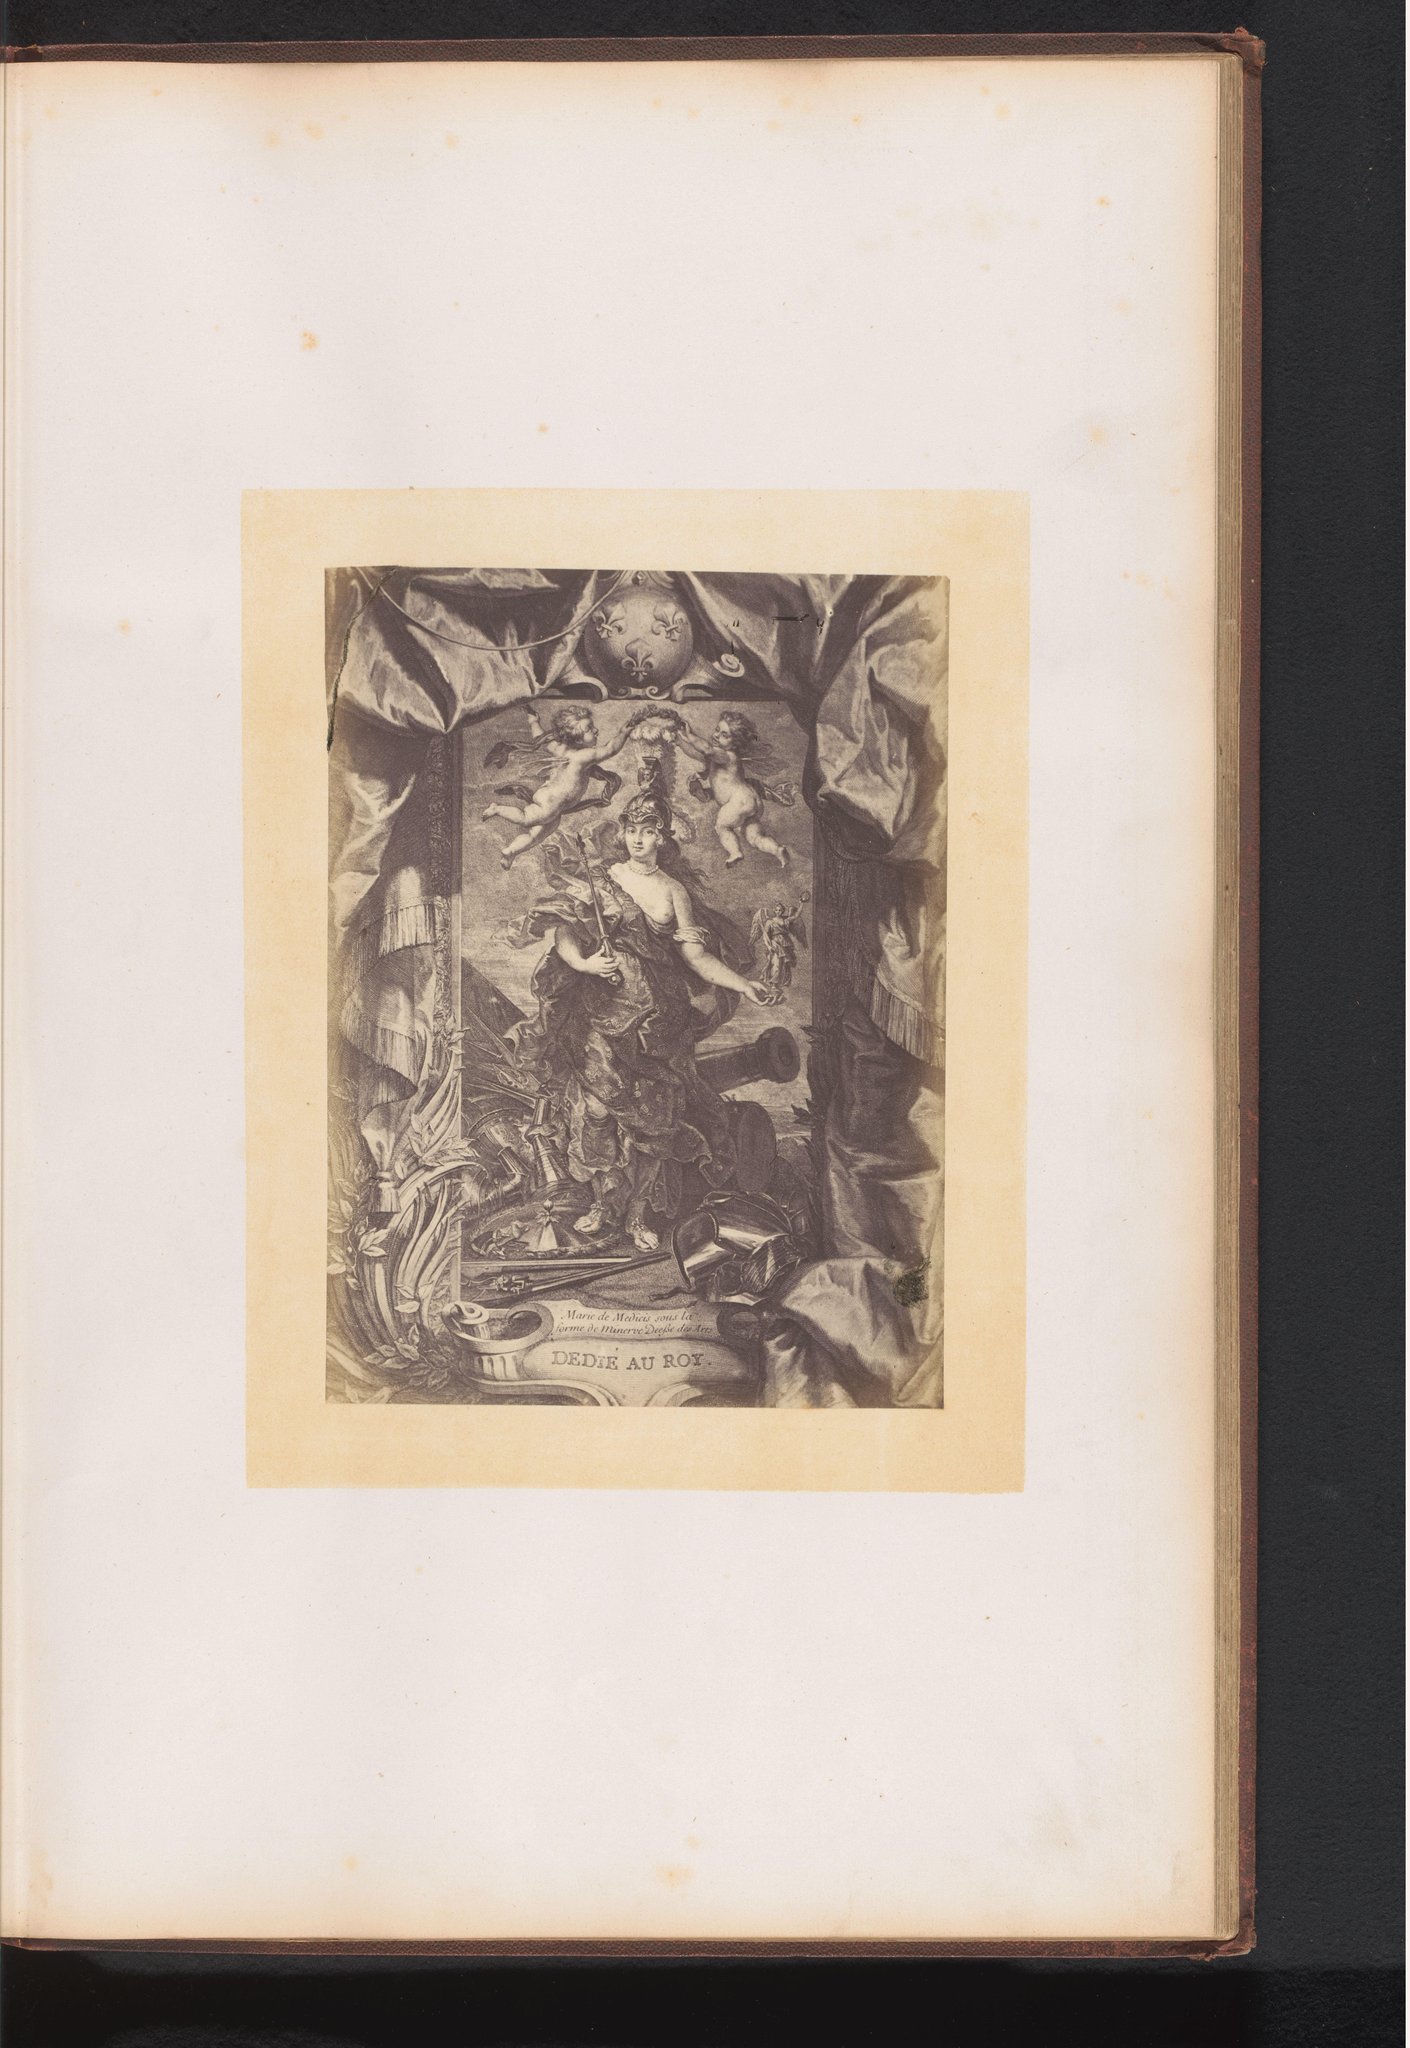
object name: photograph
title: Fotoreproductie van een gravure van een portret van Maria de'Medici als Minerva door Jean-Marc Nattier, naar het schilderij door Peter Paul Rubens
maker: peter paul rubens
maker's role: draughtsman, painter, print maker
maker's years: 1577-1640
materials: photographic support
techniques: albumen print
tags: cologne, print maker, maria de' medici, (story of) minerva (pallas, athena), historical persons - bb - woman